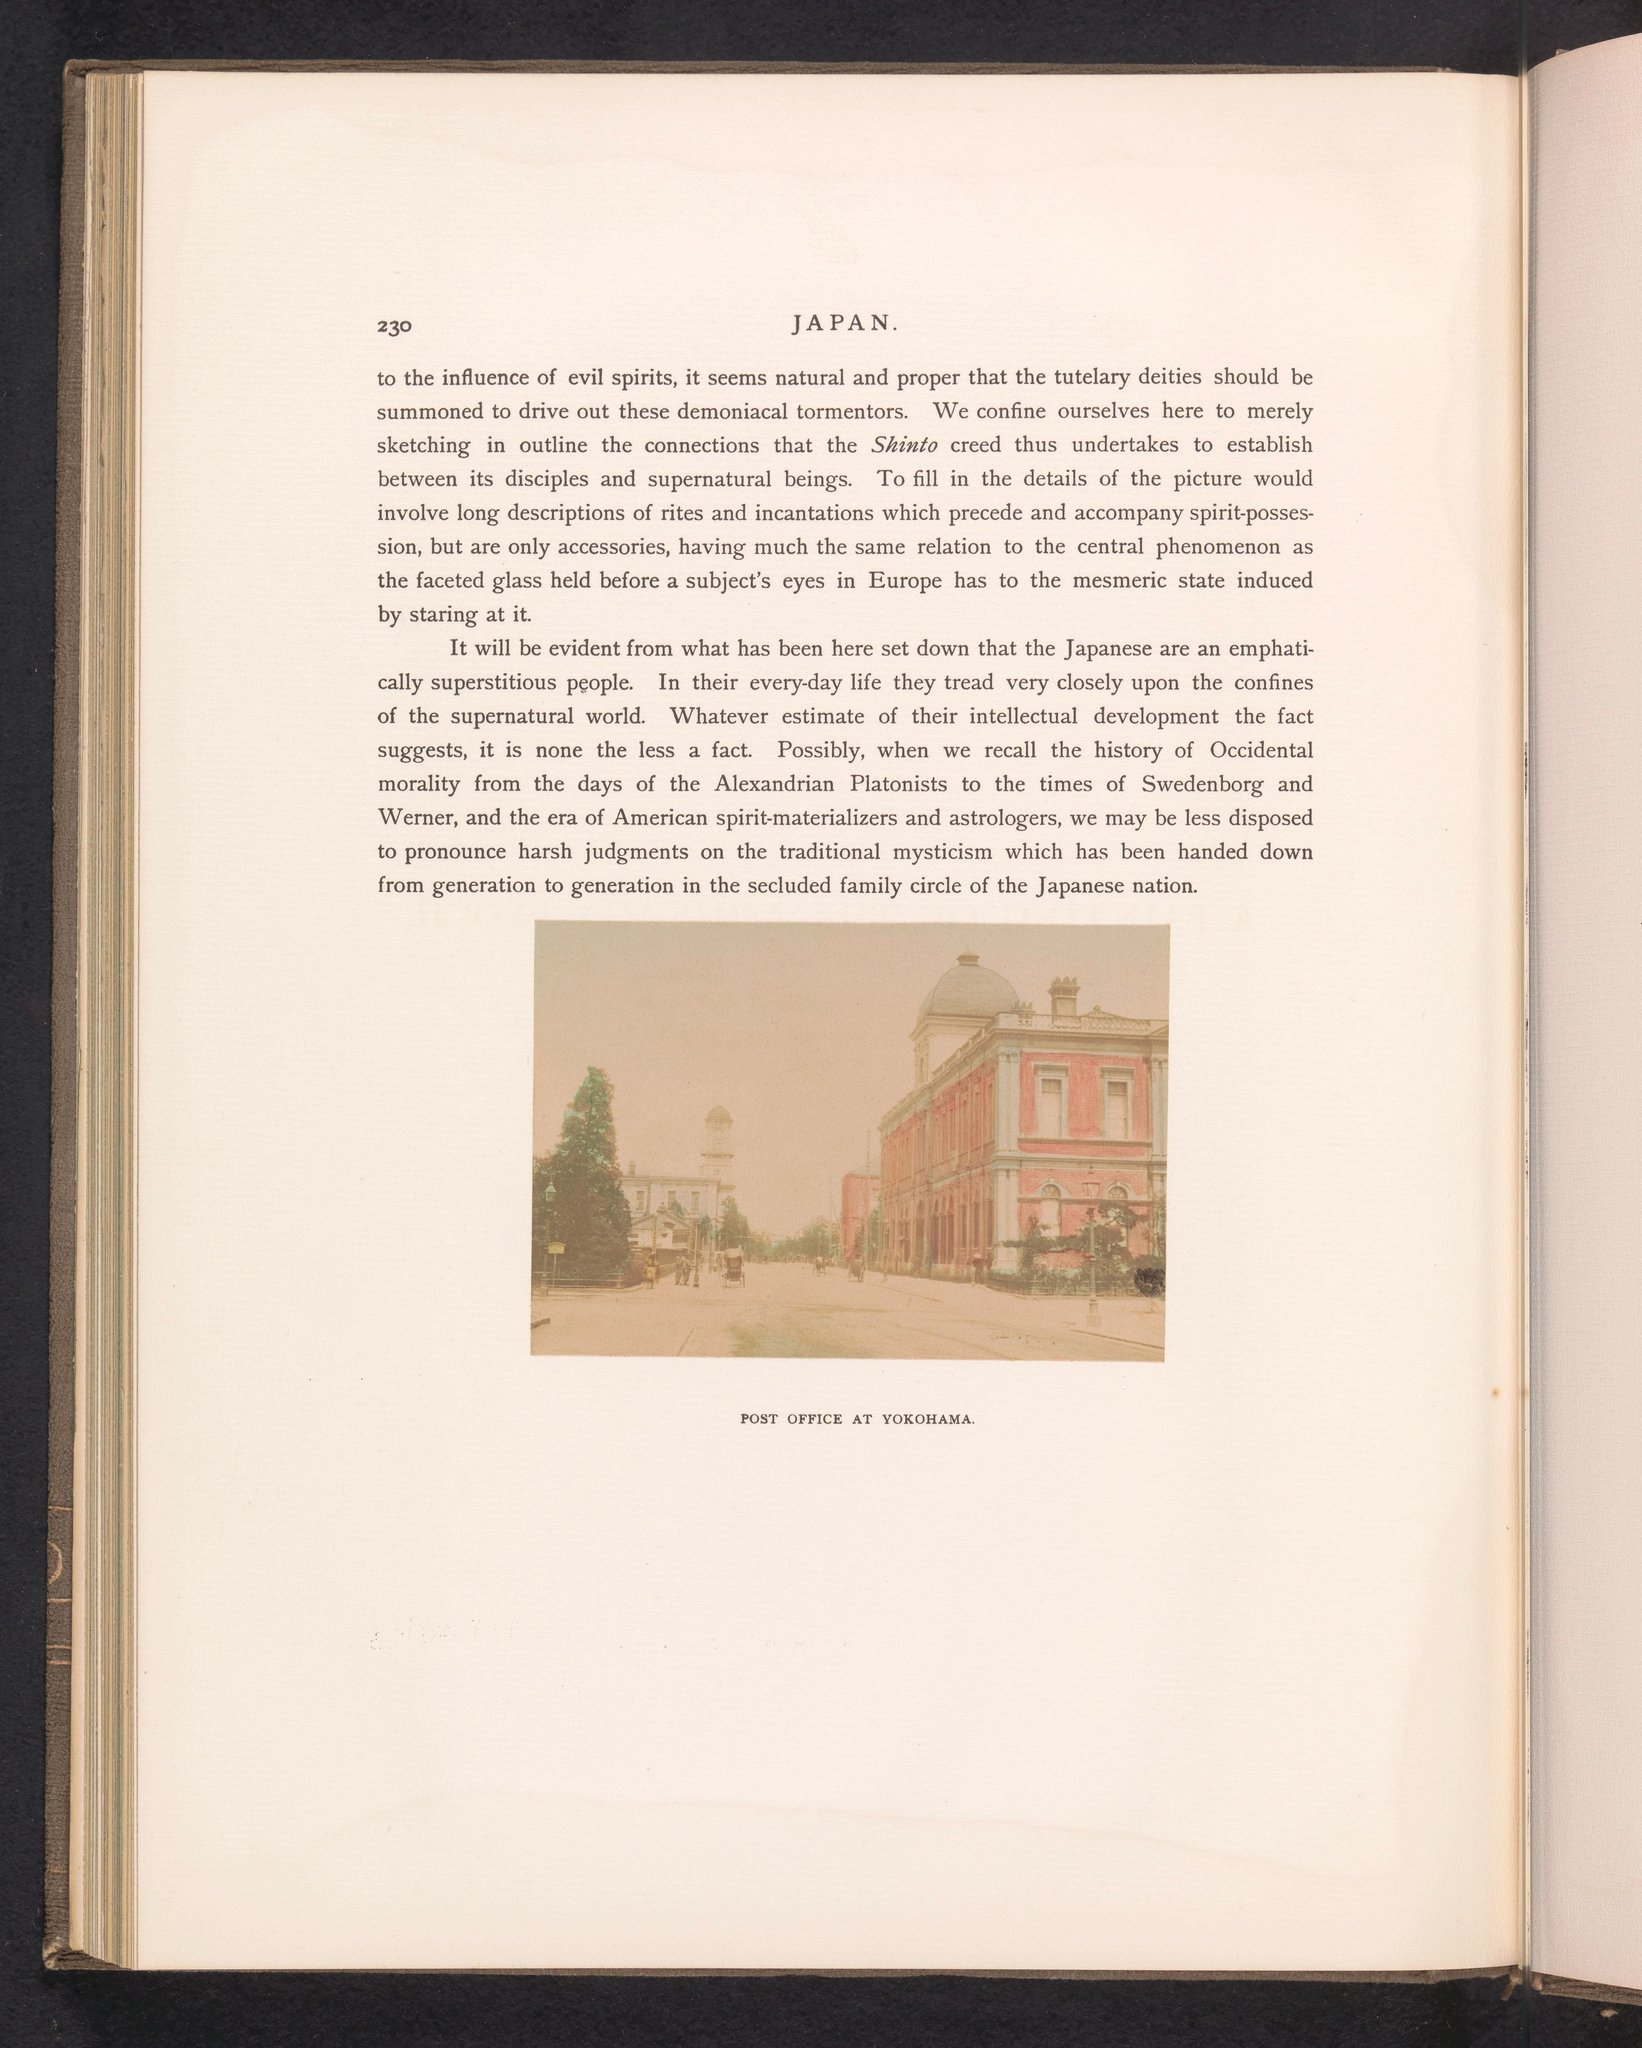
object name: photograph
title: Post office at Yokohama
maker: Anonymous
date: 1887-1897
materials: photographic support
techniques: albumen print, hand coloring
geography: japan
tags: post-office, street